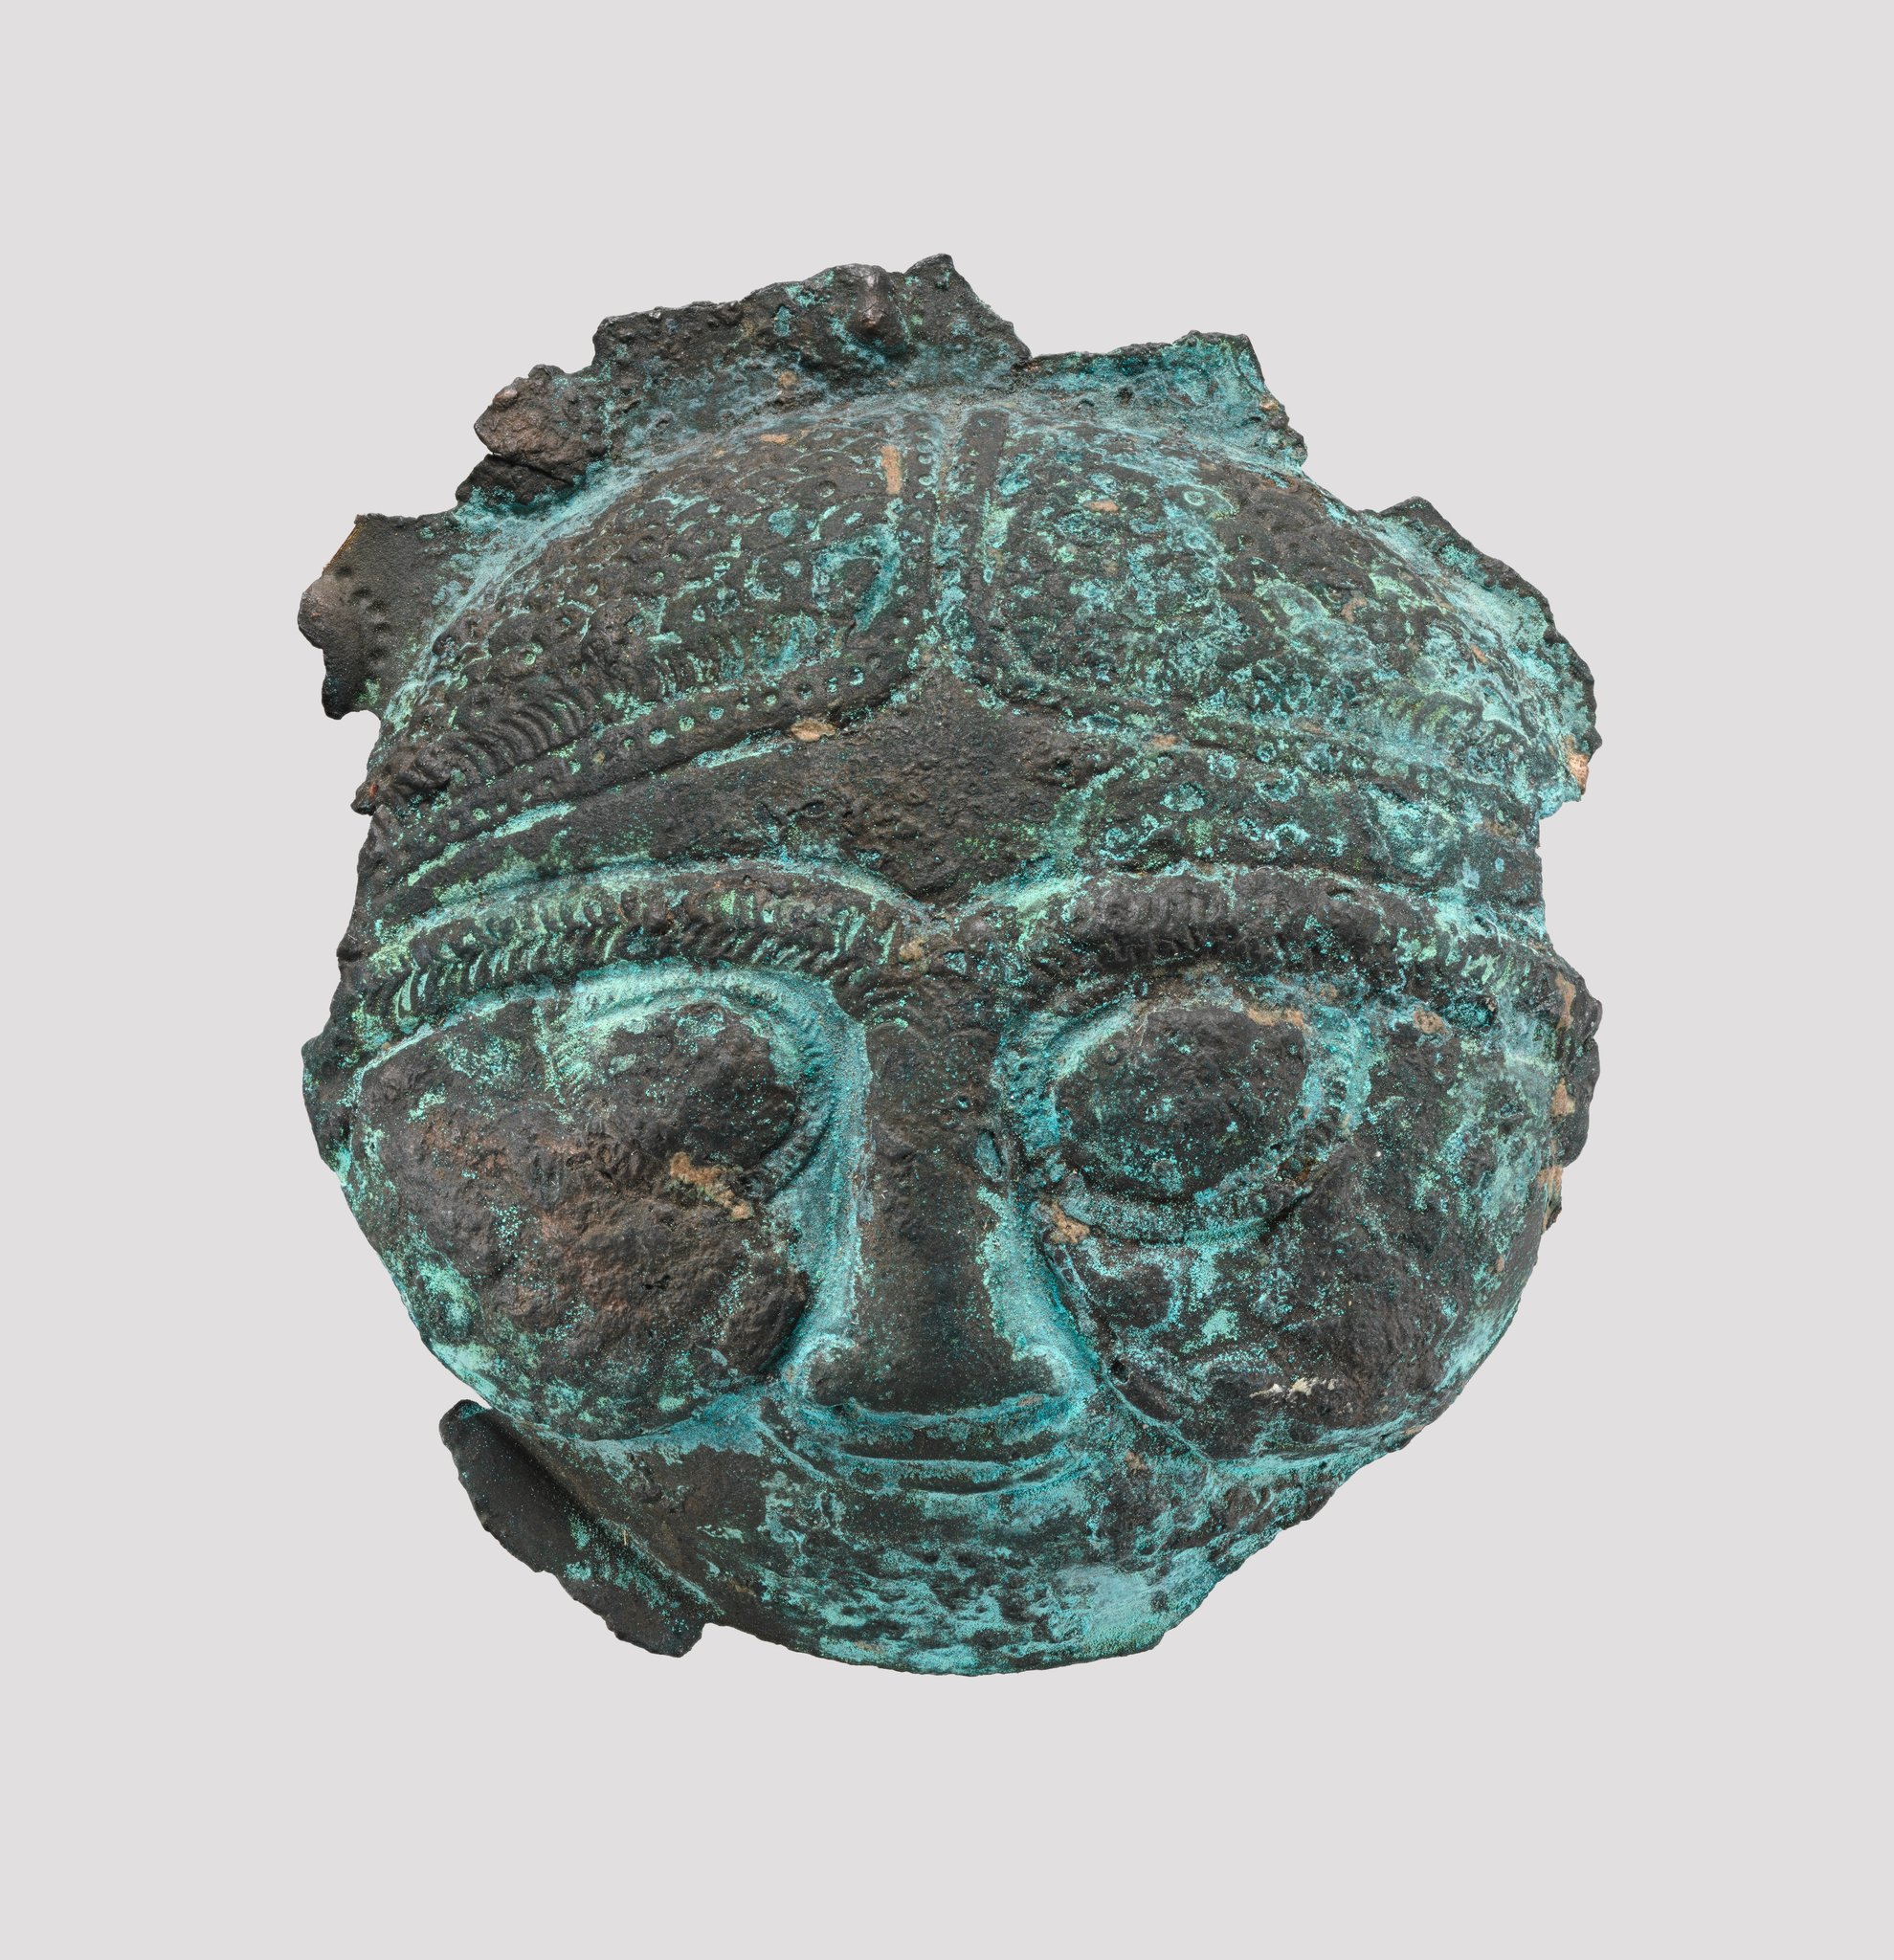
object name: bos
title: Boss from a disc-headed pin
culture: iranian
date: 800-601 BCE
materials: bronze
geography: iran, luristan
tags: heads